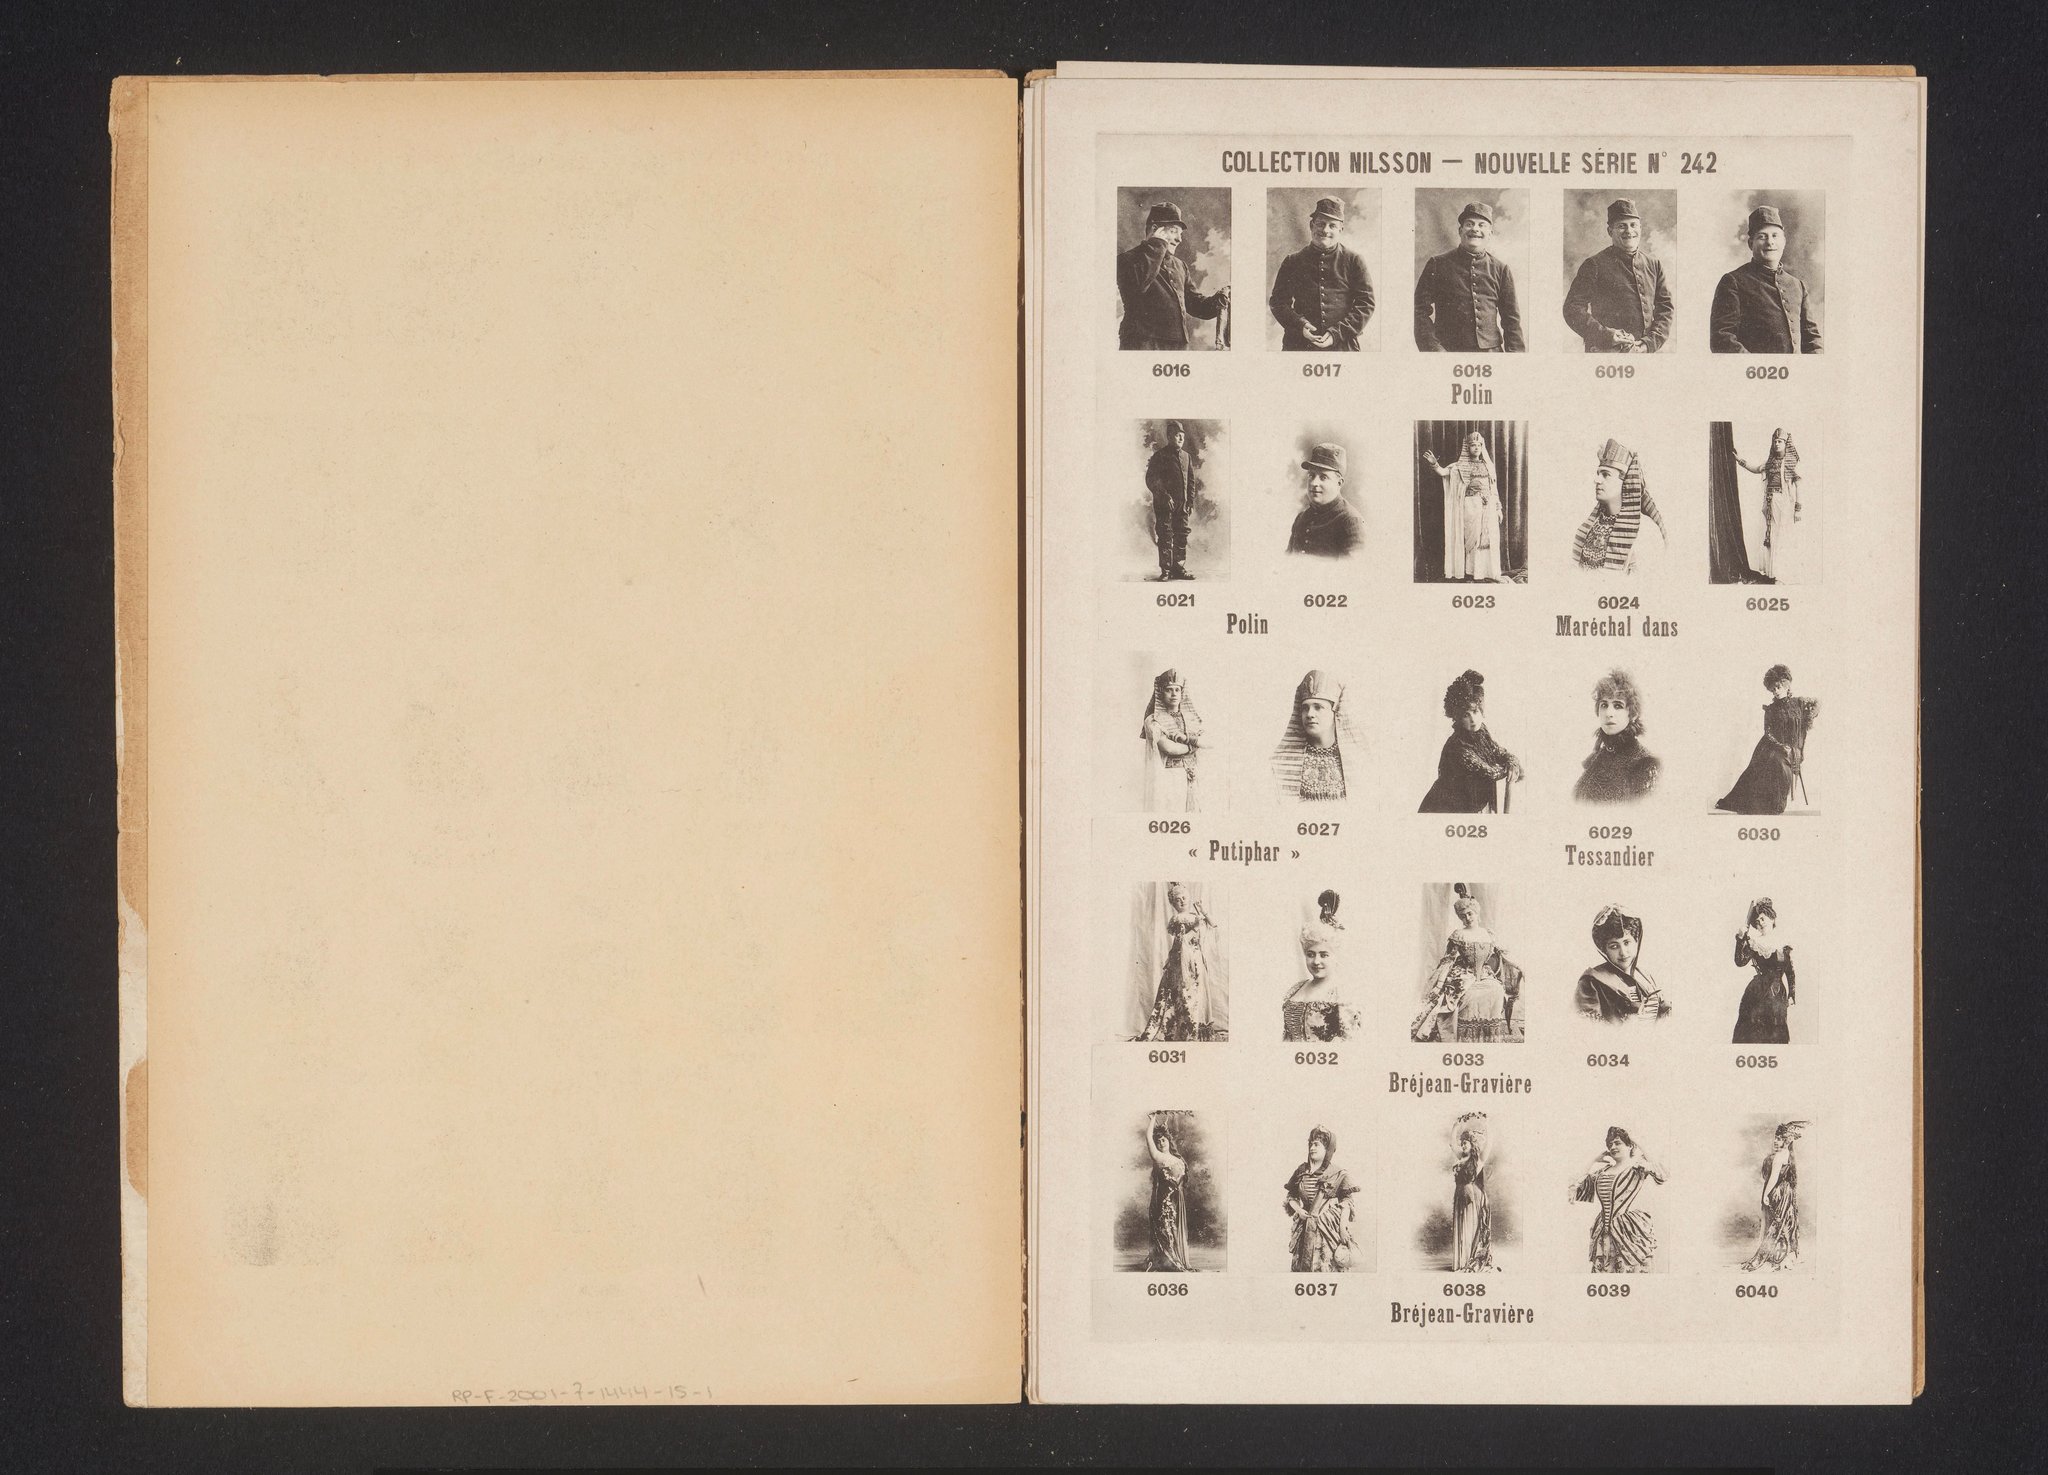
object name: page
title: 25 portretten van Polin, Maréchal, Tessandier en Bréjean-Gravière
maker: Anonymous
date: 1894-1899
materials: paper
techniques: photograph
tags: historical persons - bb - woman, historical persons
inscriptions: number: ‘No 242’, inscription: ‘Polin/ Polin Maréchal dans/ < < Putiphar > > Tessandier/ Bréjean-Gravière/ Bréjean-Gravière’